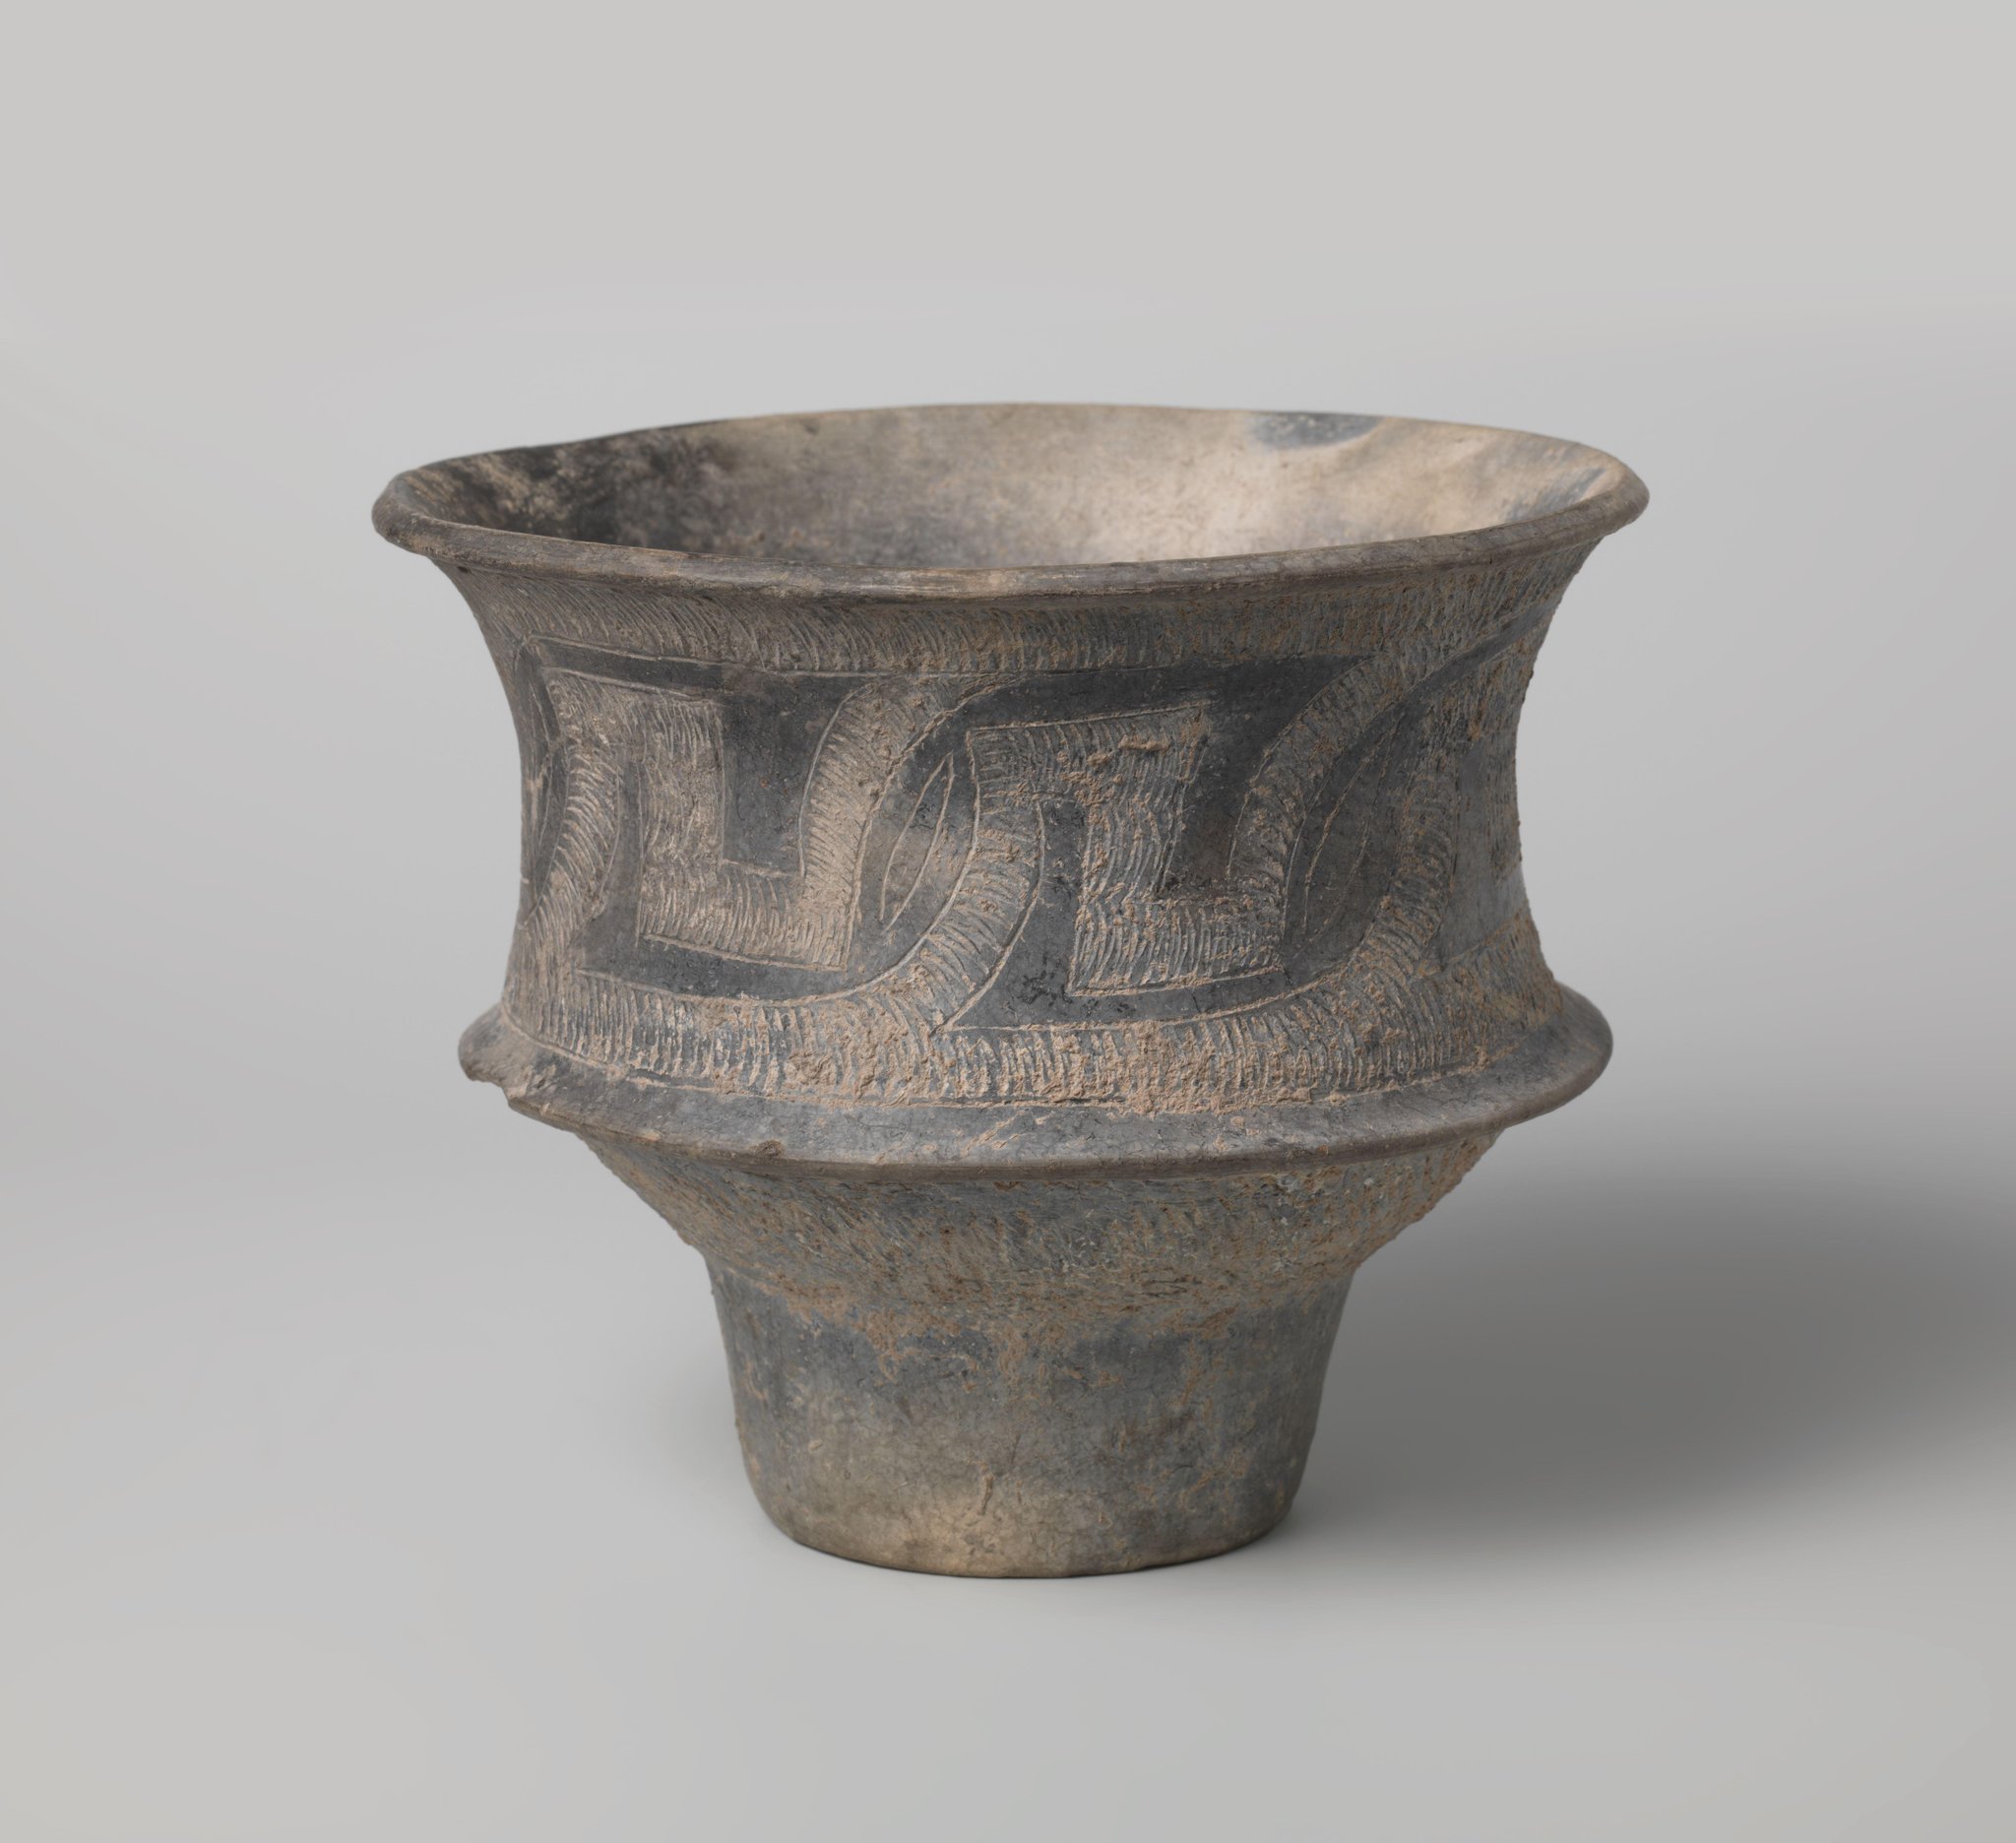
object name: pot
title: Jar with geometric patterns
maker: Anonymous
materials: earthenware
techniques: engraving, forming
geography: ban chiang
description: Pot van aardewerk op een hoge, smalle voet en een concave wand. De pot is gearceerd met geometrische motieven uitgespaard op de buitenwand.